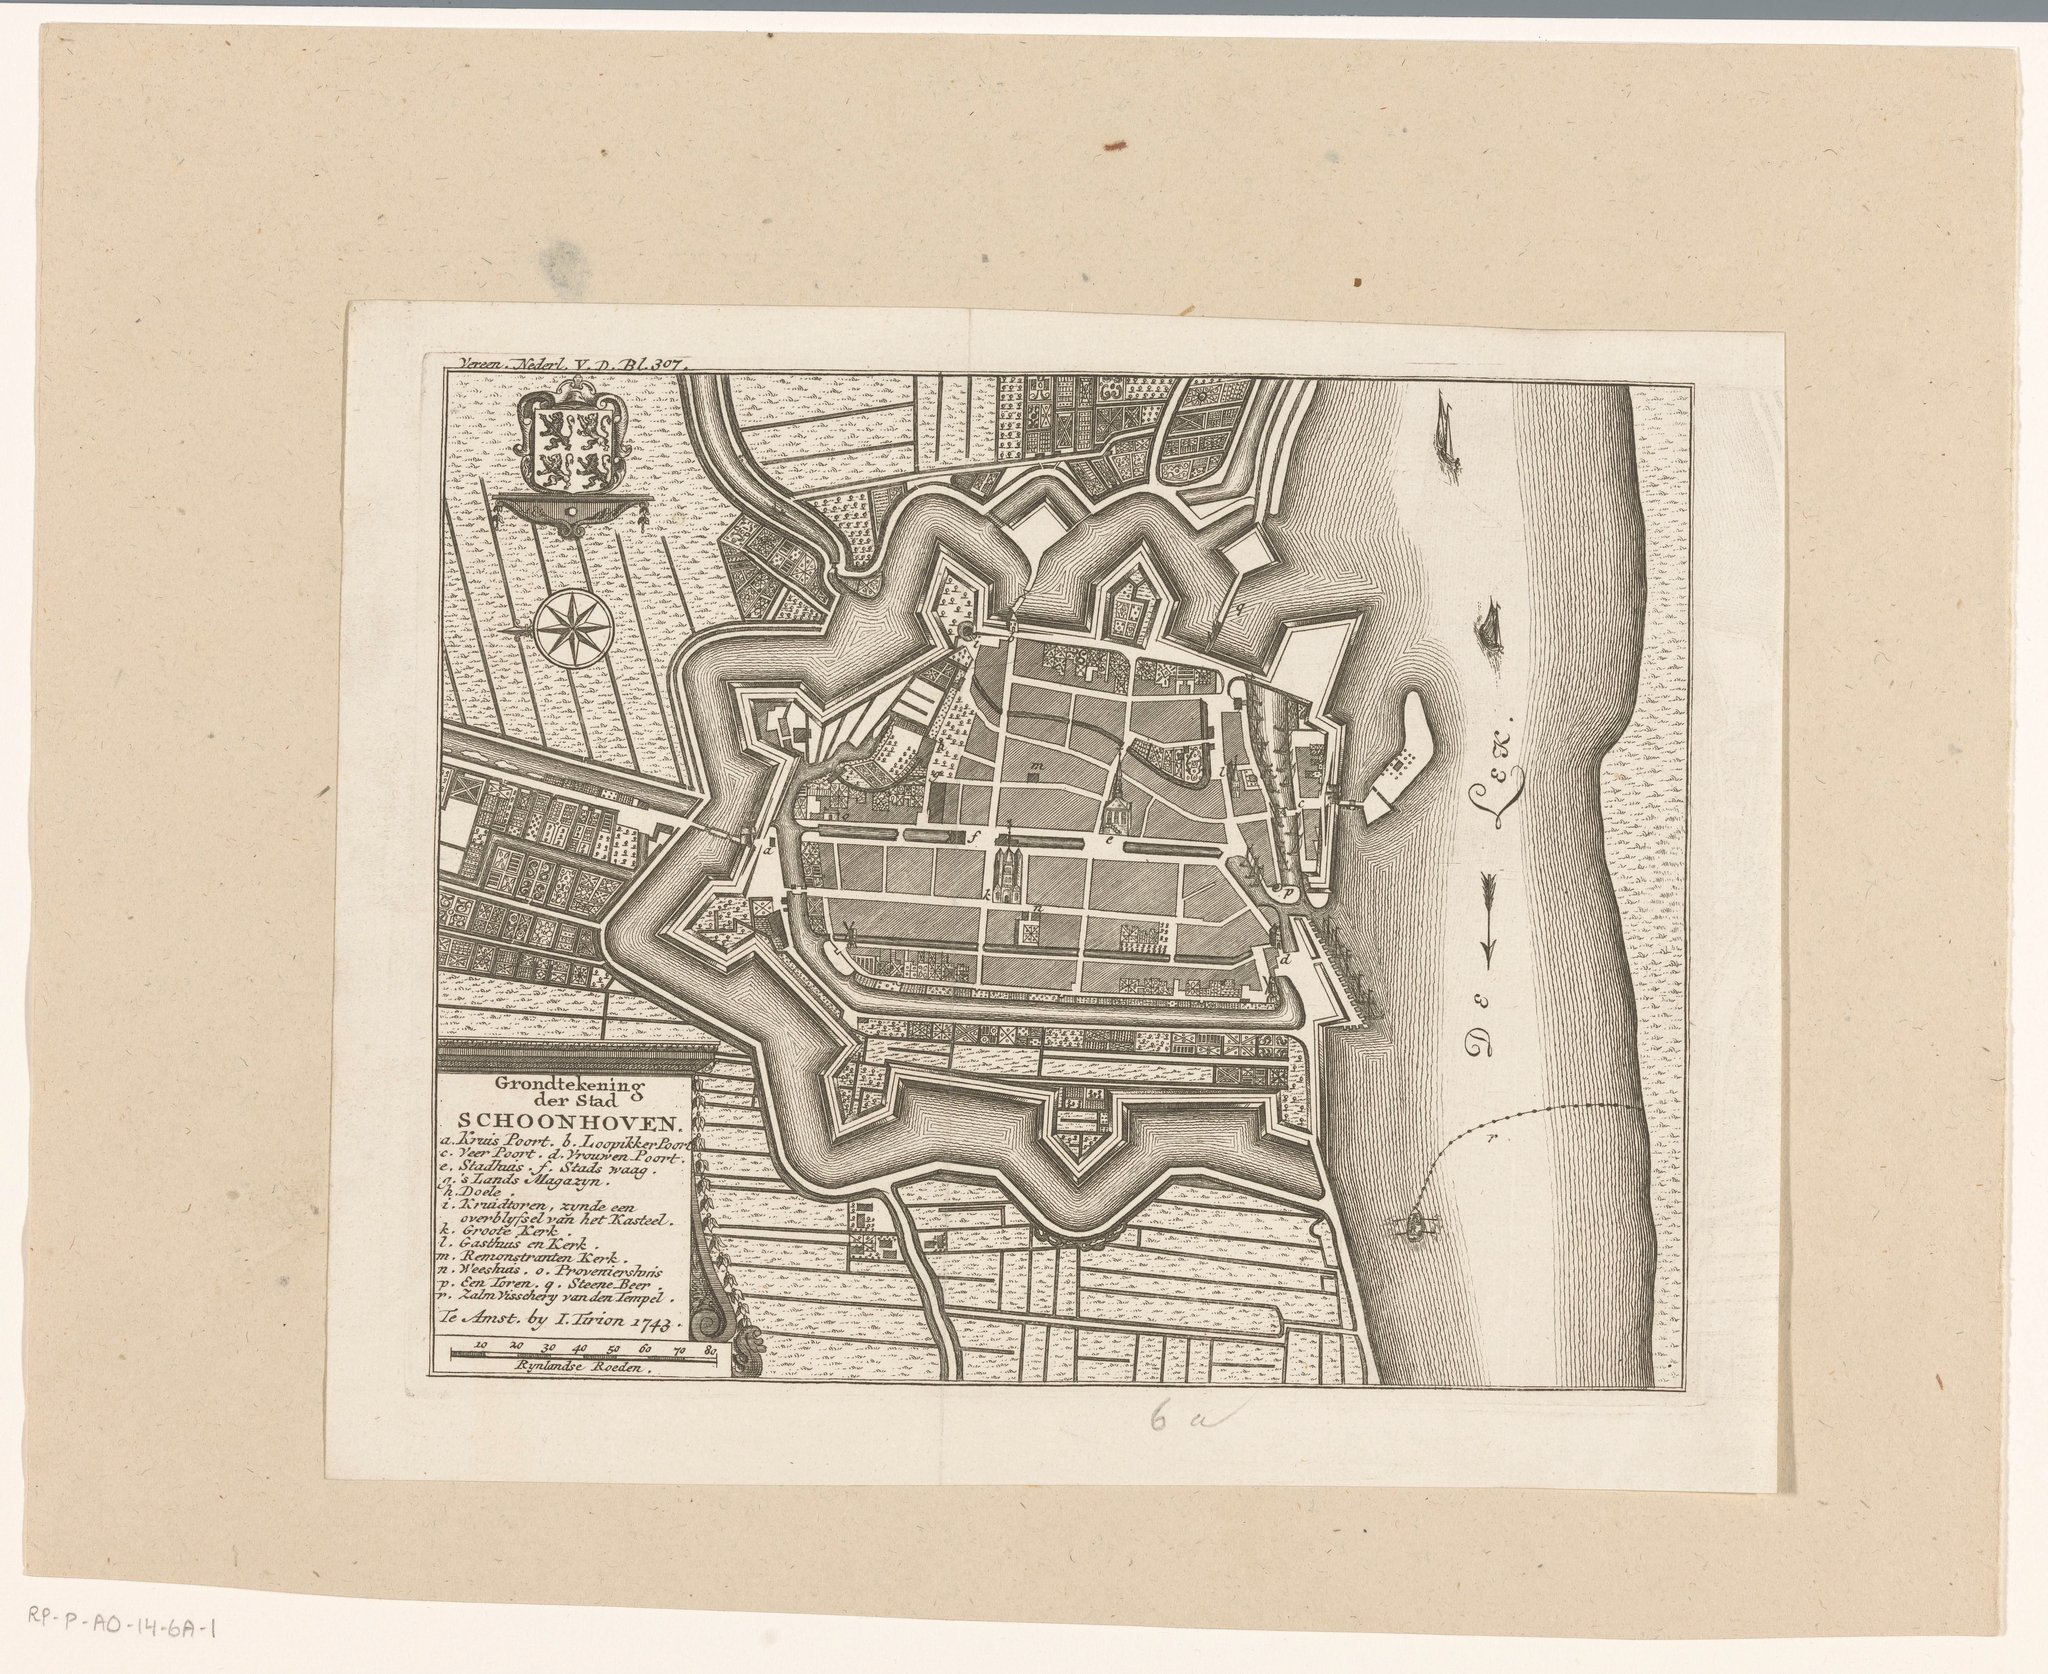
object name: print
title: Grondtekening der stad Schoonhoven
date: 1743-1744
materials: paper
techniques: engraving, etching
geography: amsterdam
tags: coat of arms (as symbol of the state, etc.) (+ city; municipal), maps of cities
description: Prent ook gebruikt in: Wagenaar, Jan. Tegenwoordige staat der Vereenigde Nederlanden, vyfde deel. Behelzende het vervolg der beschrijvinge van Holland. Met naauwkeurige plans der steden en printverbeeldingen versierd / Hedendaagsche historie, of tegenwoordige staat van alle volkeren; XVde deel (…). Amsterdam: Isaak Tirion, 1744, tussen p. 306 en 307. Latere staat van prent ook gebruikt in: Beknopte atlas, van omtrent honderd platte gronden der voornaamste vestingen, kasteelen en steden van Europa, en byzonder van de Nederlanden en eenige kolonien (…). Amsterdam: Compagnie van Boekverkopers, s.a. [na 1780].